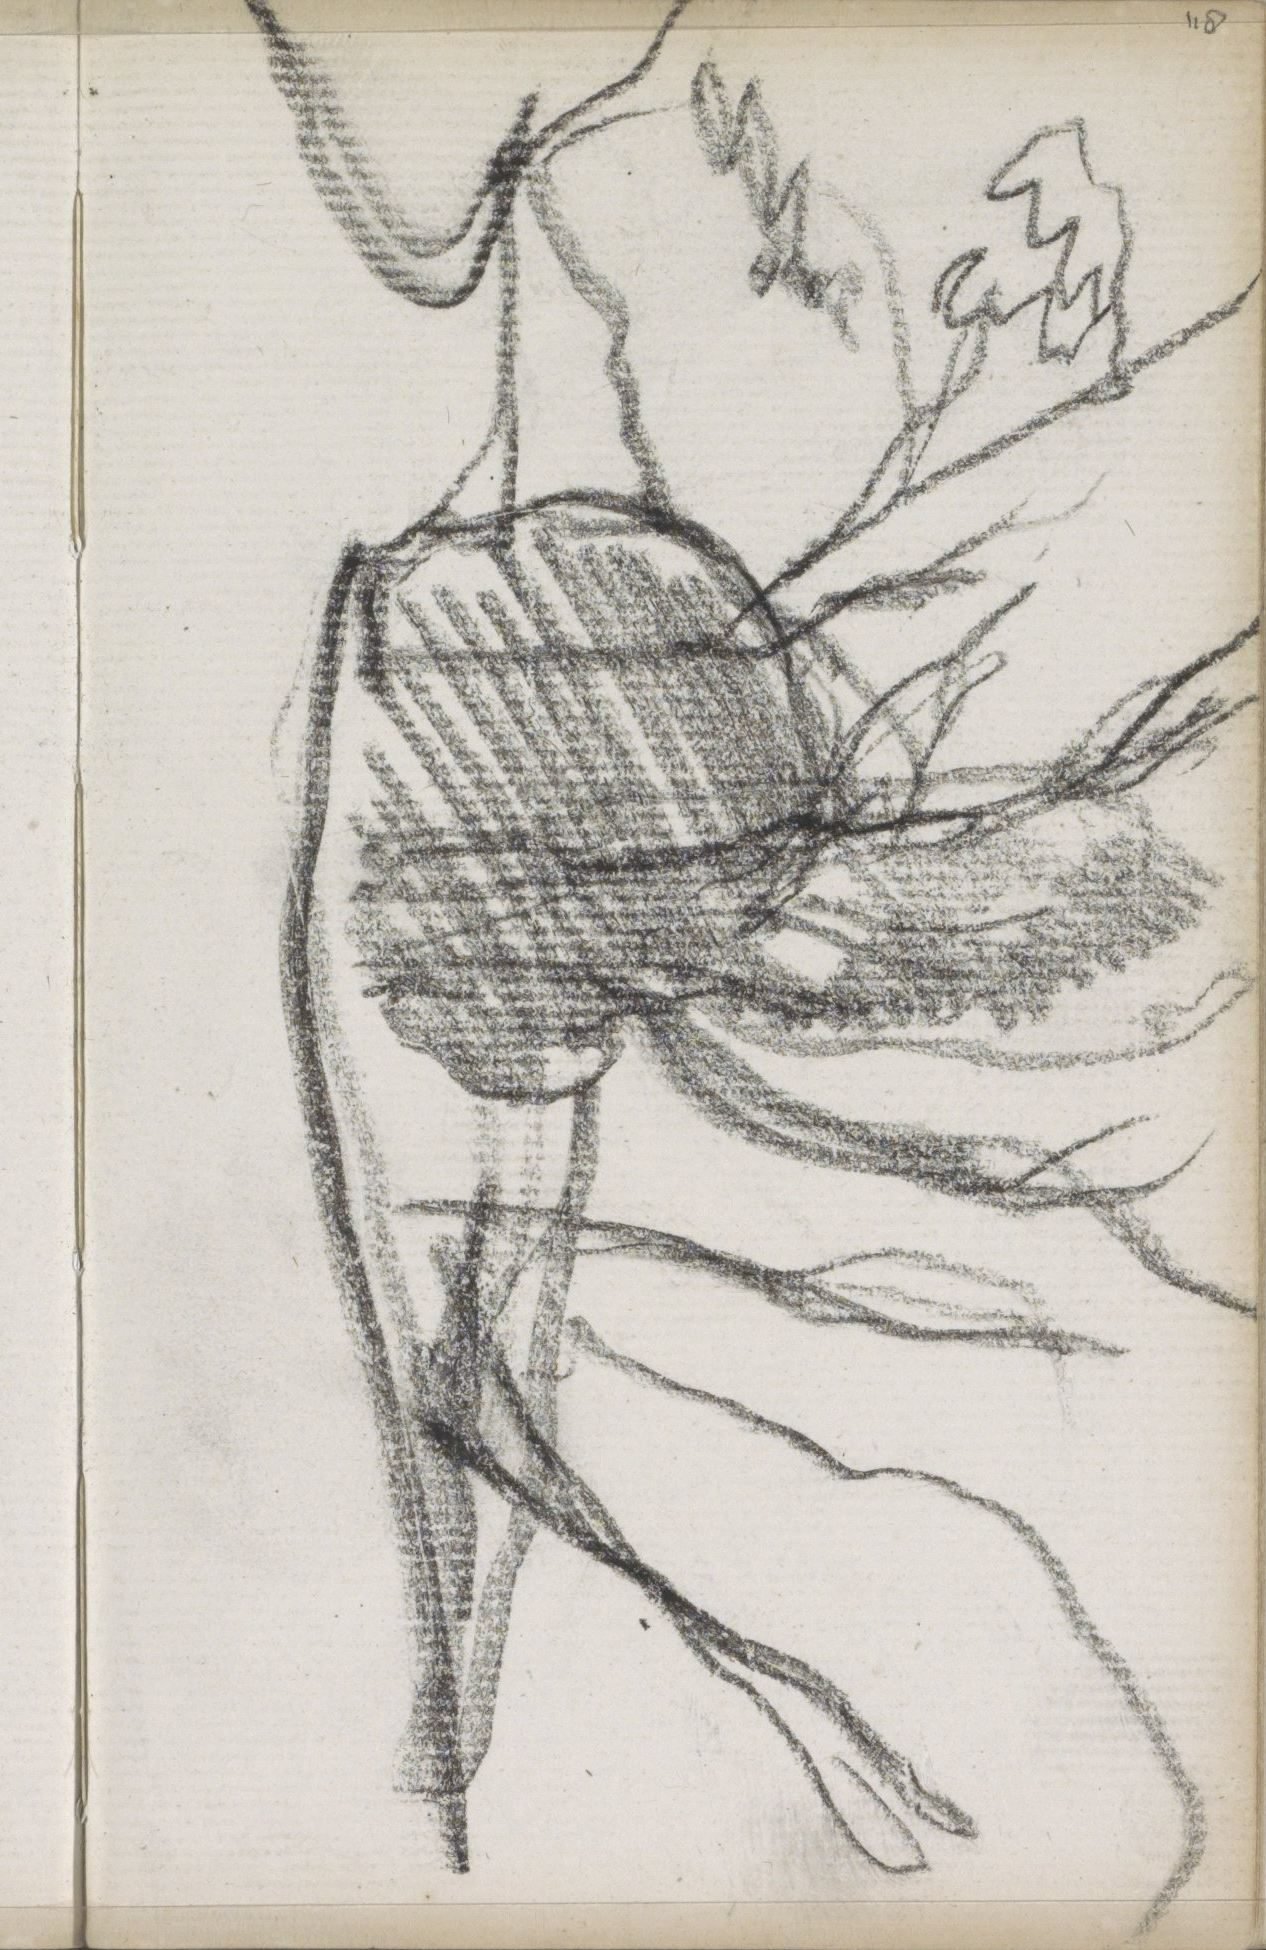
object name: sketchbook leaf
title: Studie, mogelijk van een liggend dier in een landschap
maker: george hendrik breitner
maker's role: draughtsman, painter, print maker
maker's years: 1857-1923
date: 1884-1886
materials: chalk, paper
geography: drenthe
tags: landscapes, animals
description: Pagina 118 uit een schetsboek met 67 bladen vervaardigd in Drenthe.